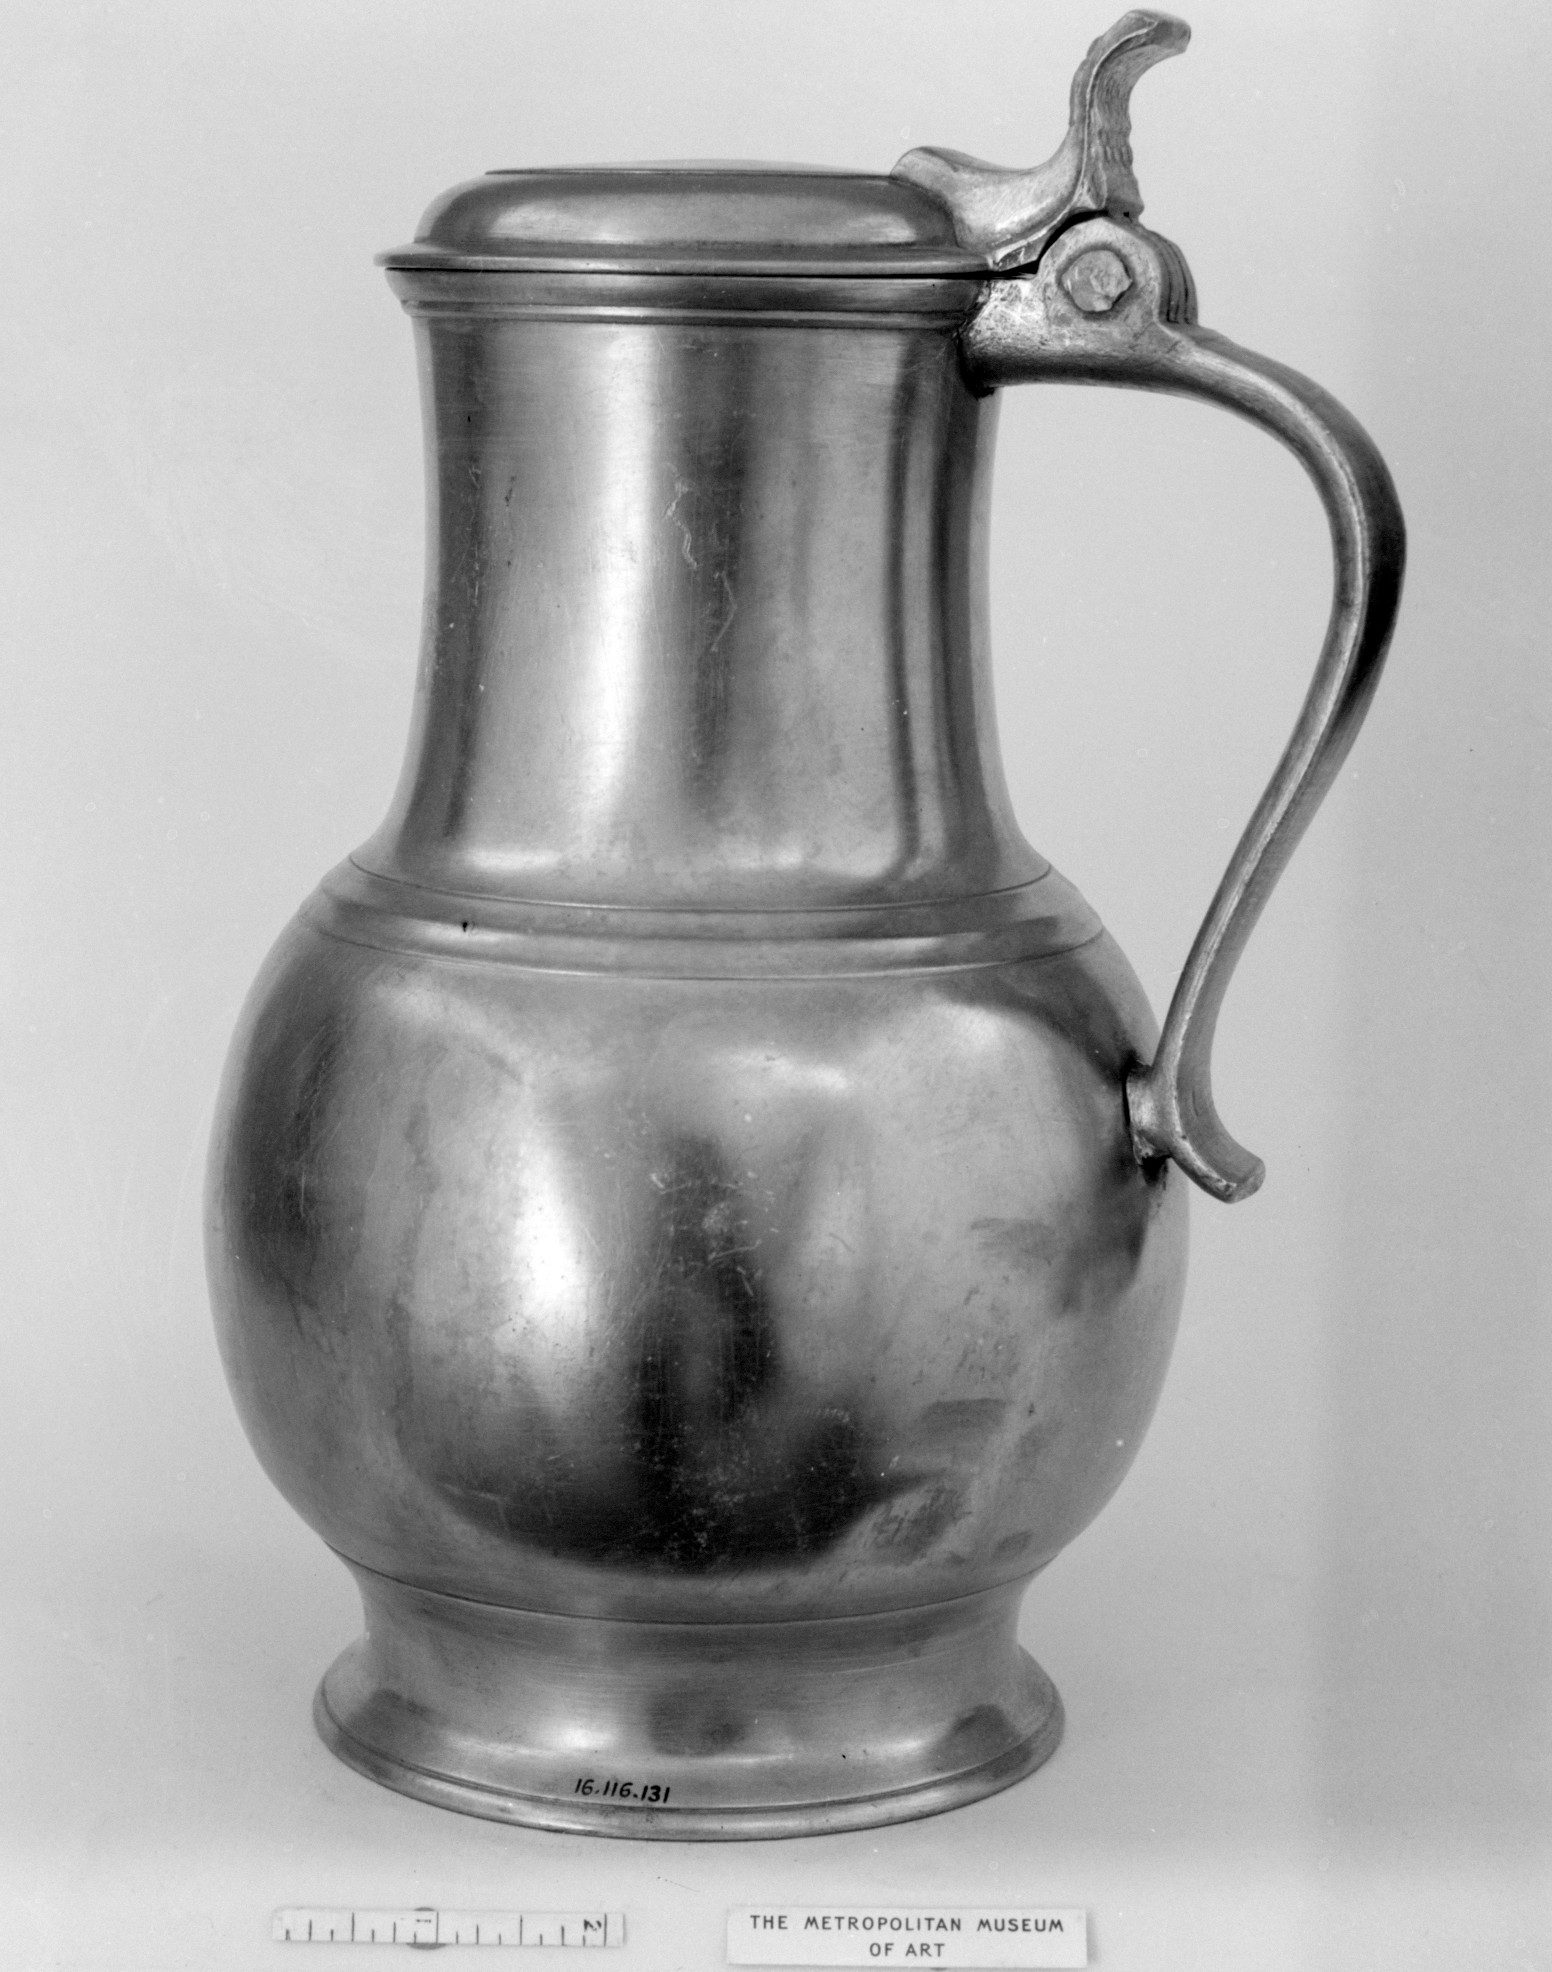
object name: flagon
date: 1701-1800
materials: pewter